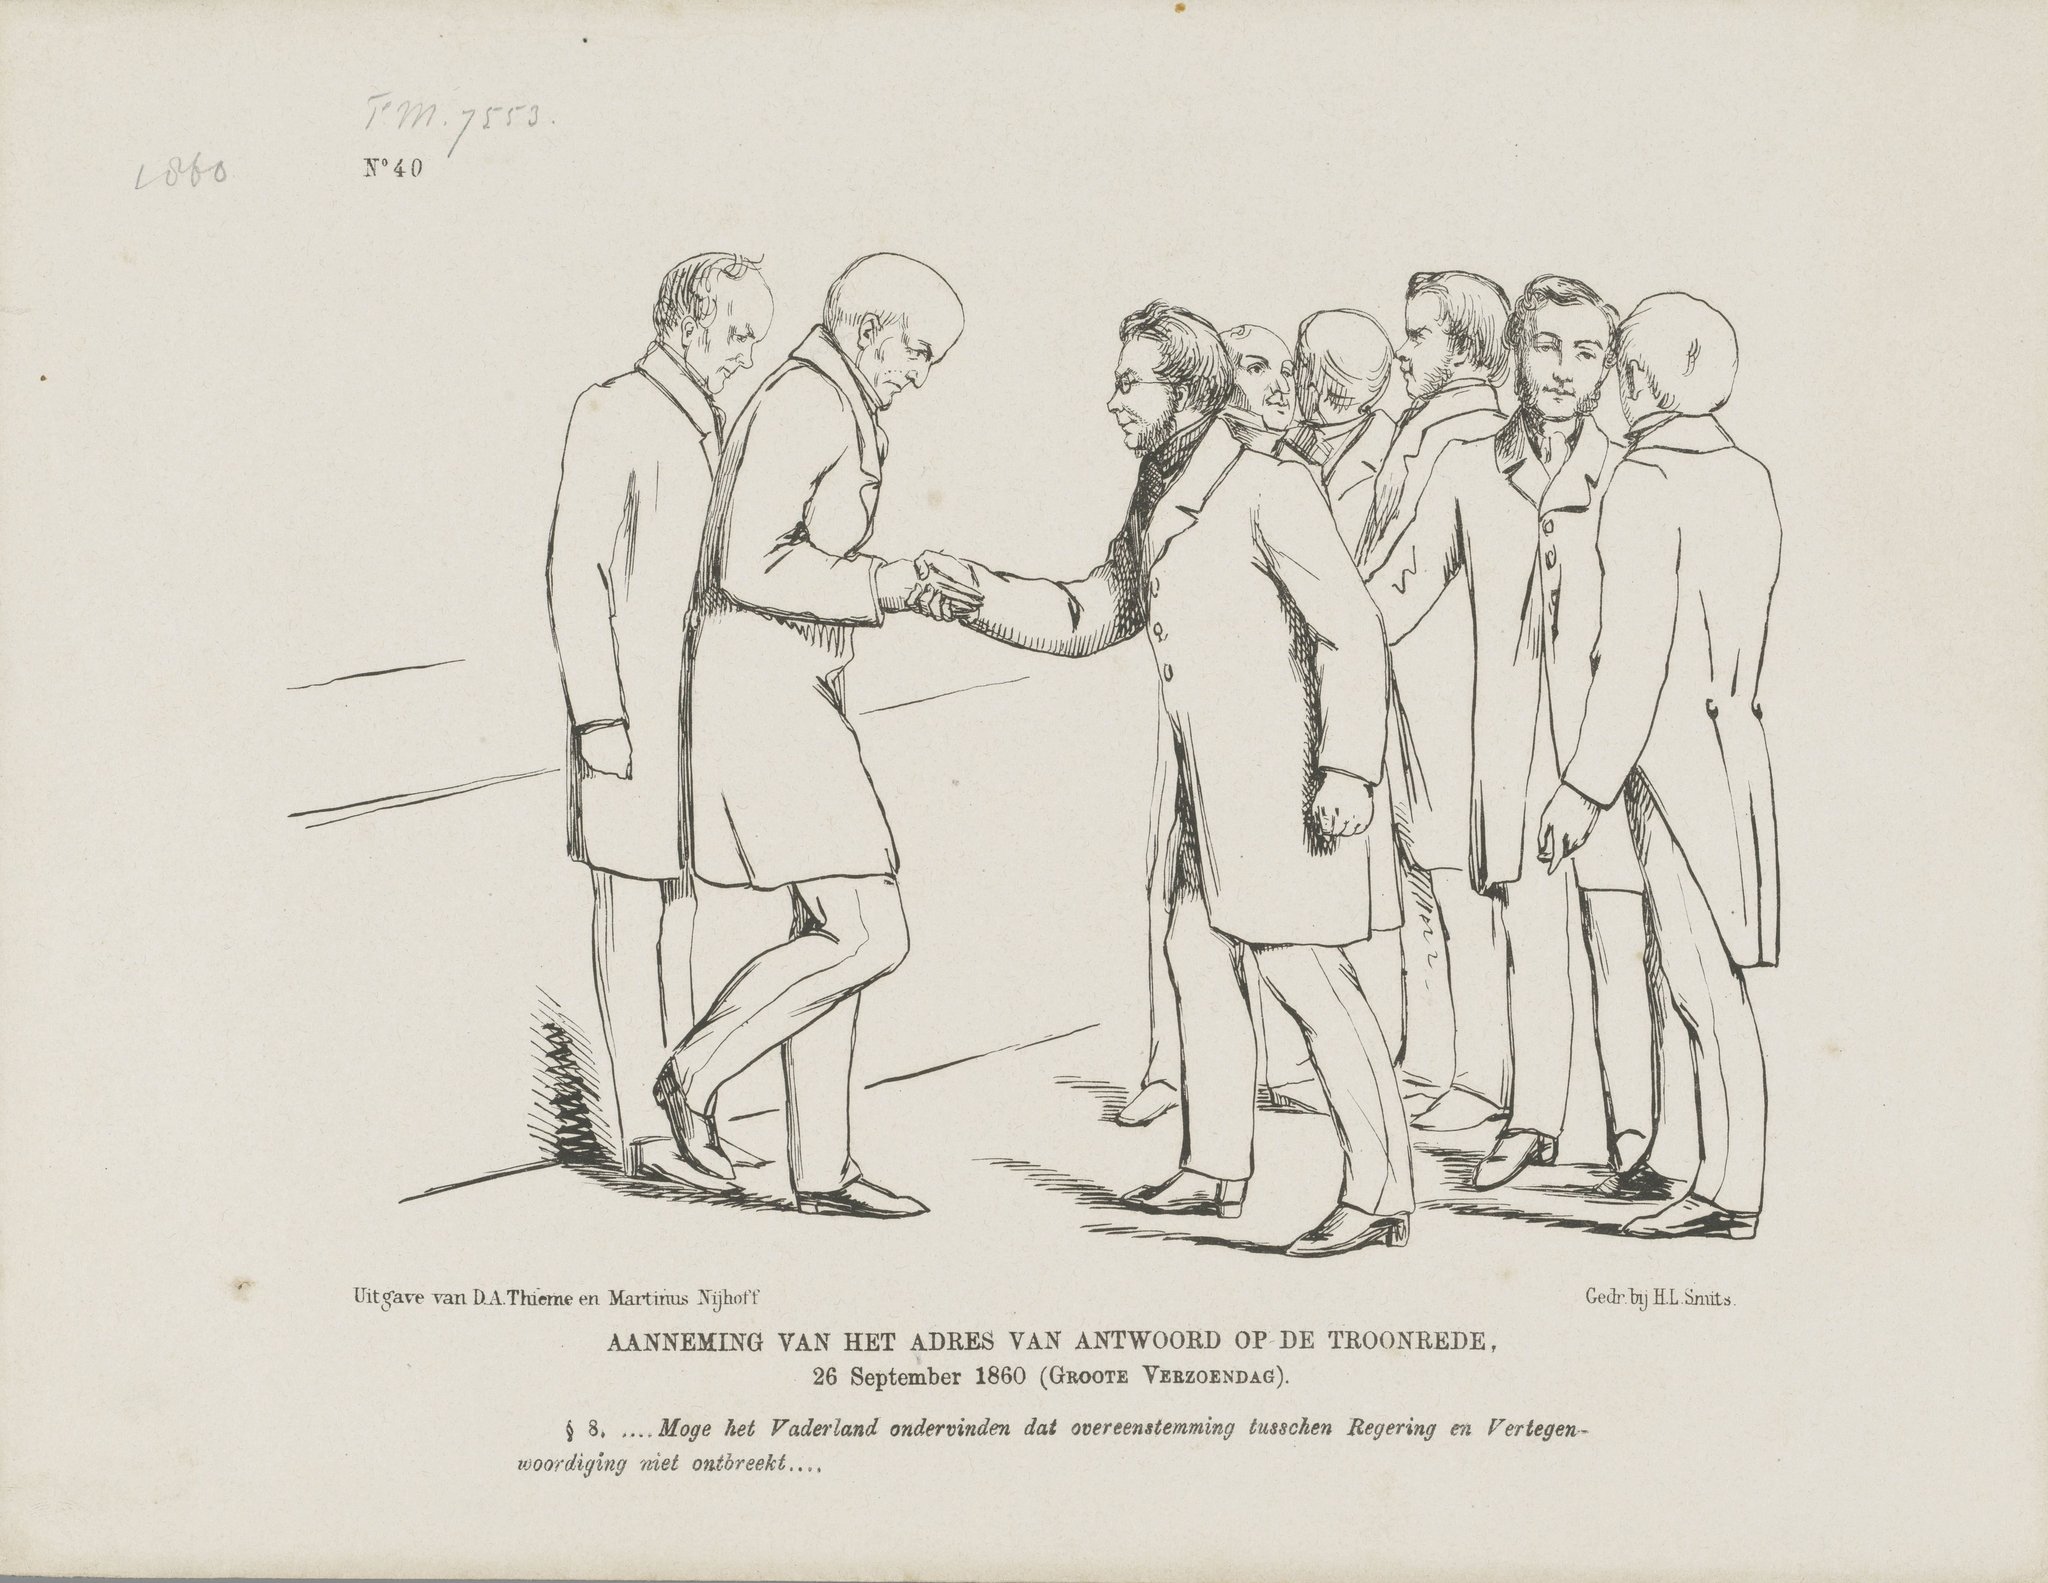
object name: print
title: Aanneming van het adres van antwoord op de troonrede, 26 September 1860 (Groote Verzoendag)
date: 1860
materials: paper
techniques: lithograph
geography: arnhem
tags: floris adriaan van hall, shaking hands, 'dextrarum junctio', lower house, parliament, chamber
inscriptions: collector's mark: Lugt 2228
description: Spotprent waarin baron van Hoëvell hardhandig de hand schudt van minister F.A. van Hall. Plaat verschenen bij het weekblad De Nederlandsche Spectator, nr. 40, 6 oktober 1860.